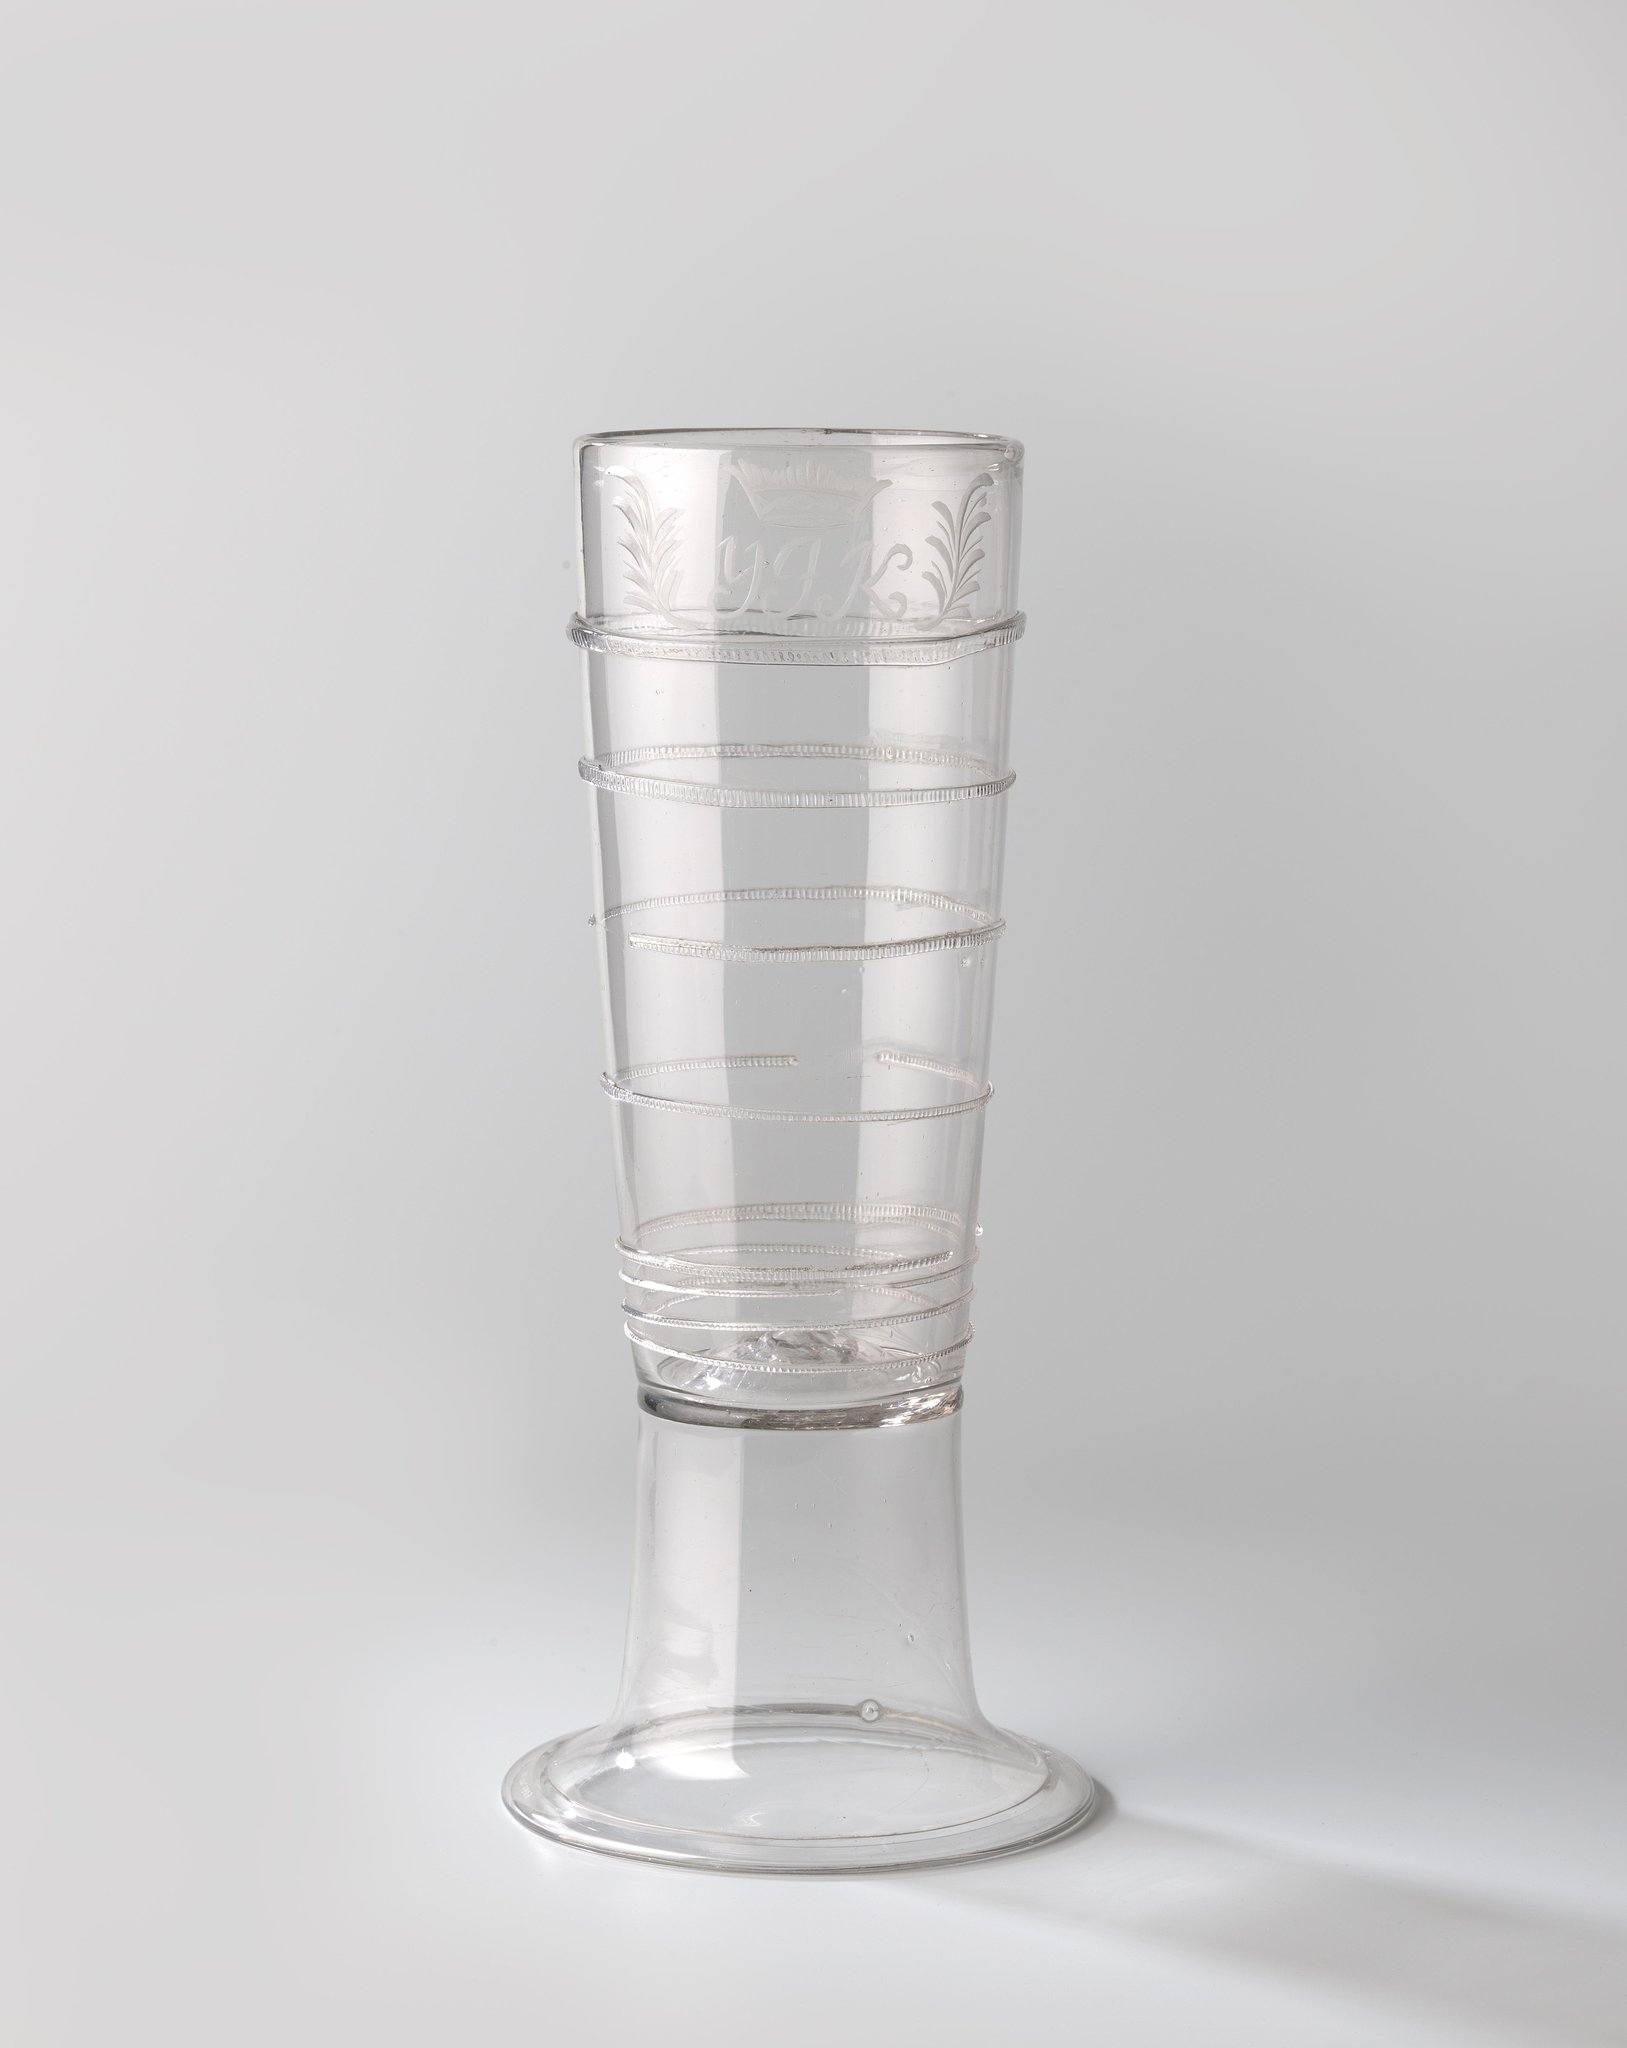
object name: pasglas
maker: Anonymous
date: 1675-1700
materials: glass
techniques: glassblowing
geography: germany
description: Pasglas van helder, kleurloos glas. Platte voet met omgeslagen rand, overgaand in de cilindrische stam. Hoge cilindrische kelk, op regelmatige afstand gedecoreerd met vier geribbelde opgelegde ringen boven een geribbelde spiraal. Boven de bovenste ring het gekroonde monogram YJK geflankeerd door bladranken.